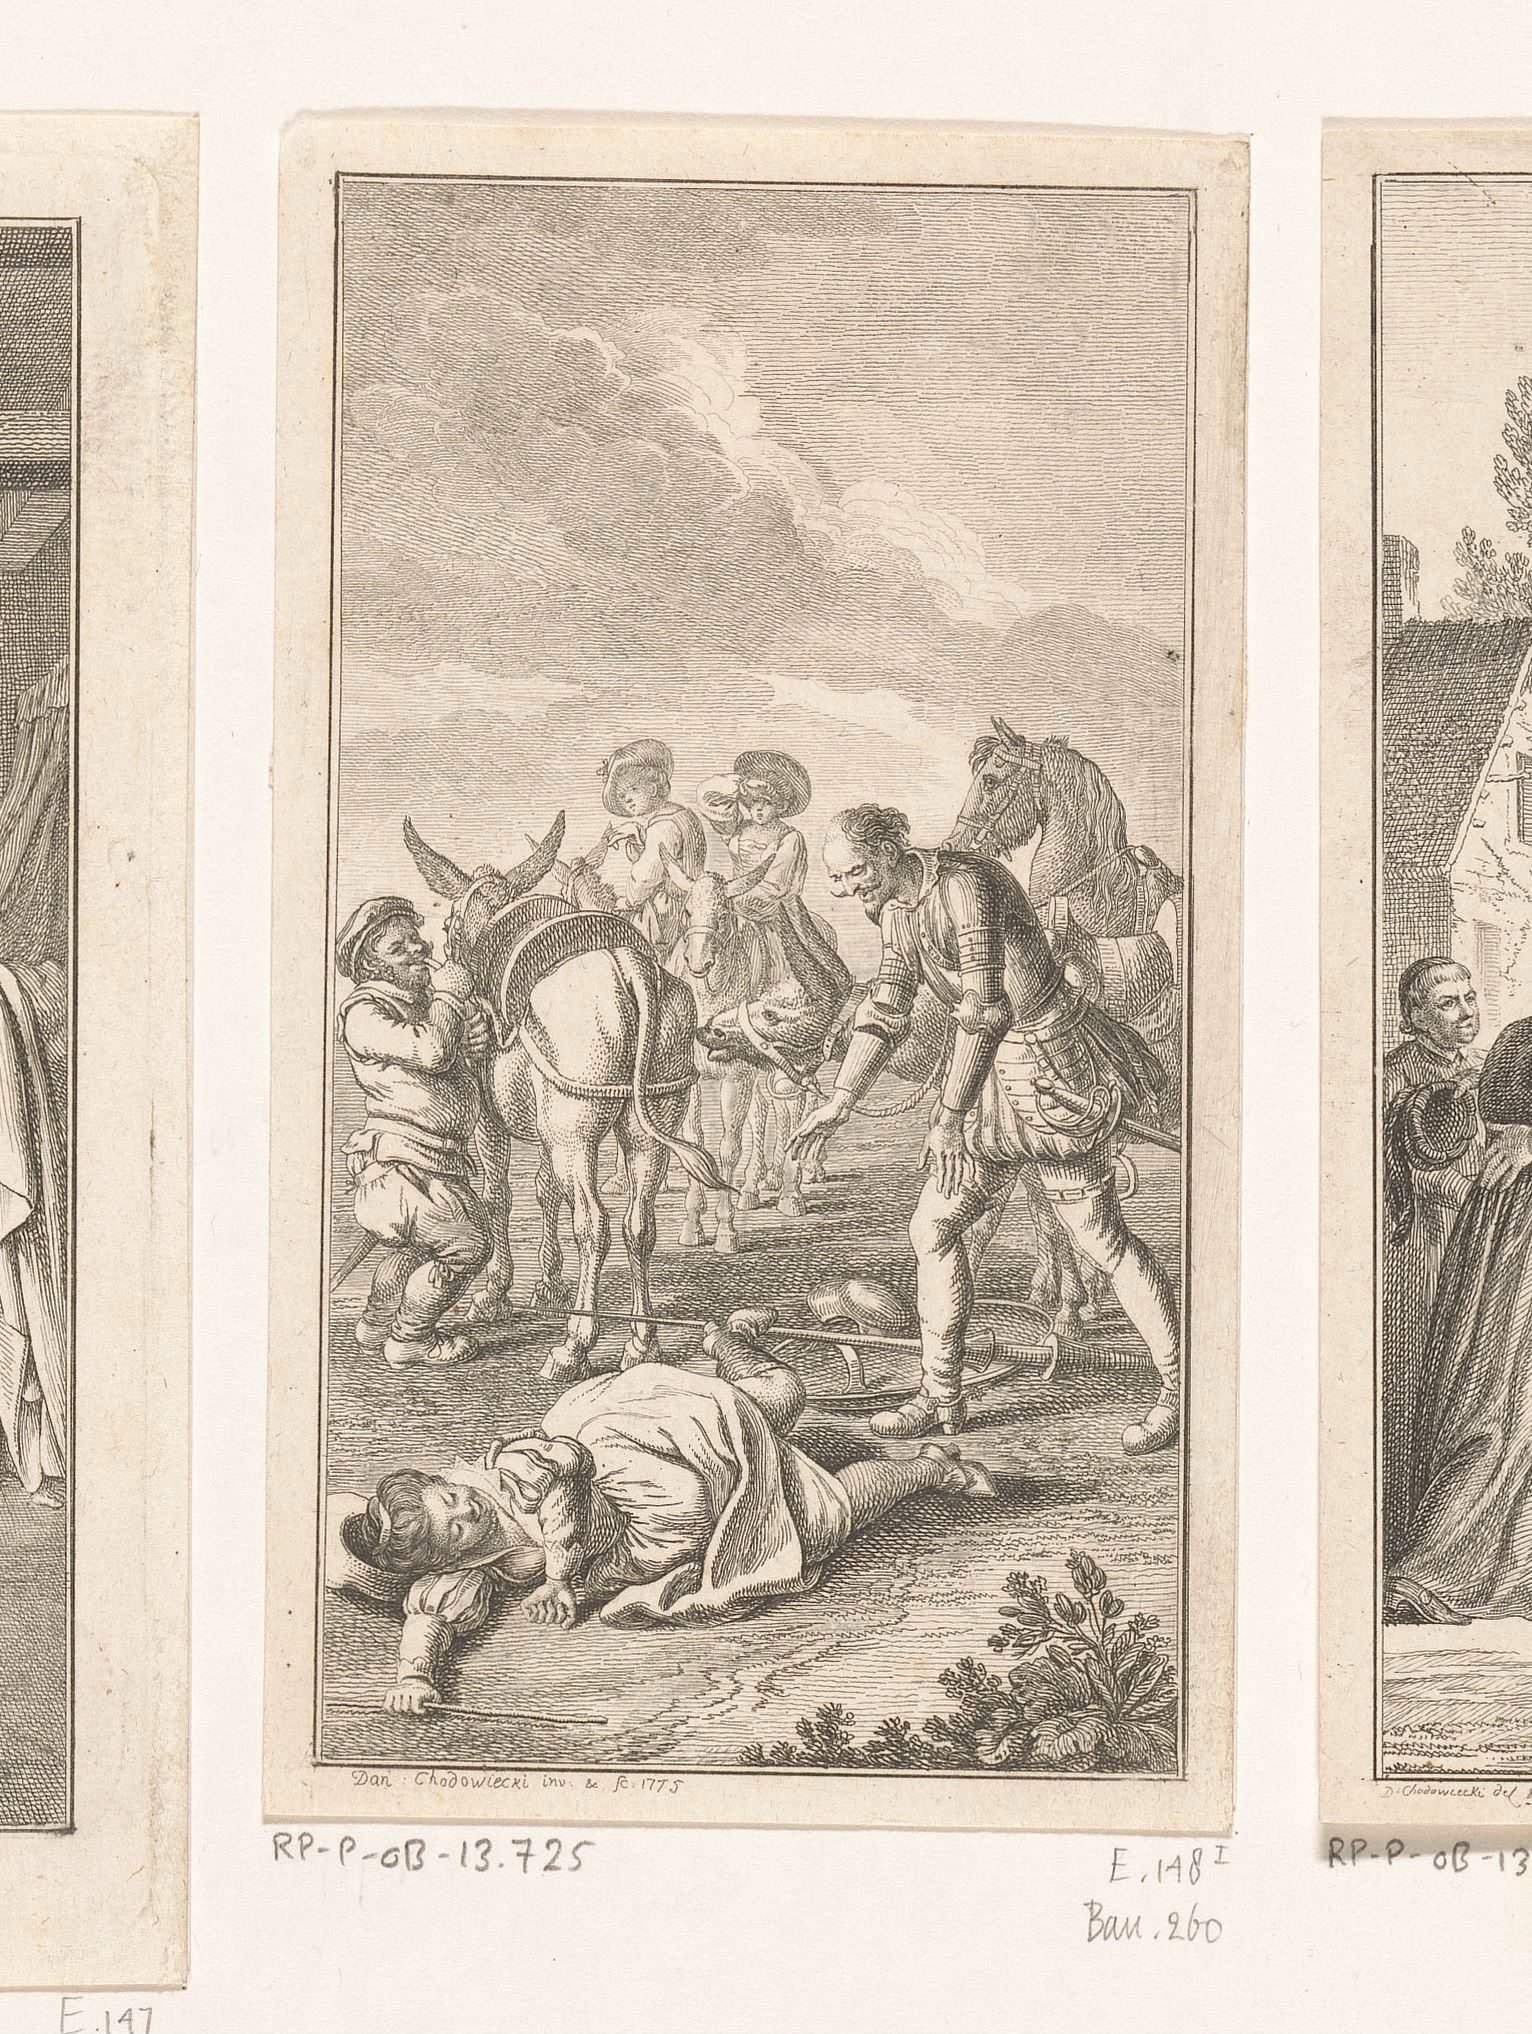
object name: print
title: Don Quichot helpt de van haar ezel gevallen boerin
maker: daniel nikolaus chodowiecki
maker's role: draughtsman, print maker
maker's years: 1726-1801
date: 1775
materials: paper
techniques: etching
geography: berlin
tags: don quixote, accident with horse (or kindred animal)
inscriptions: collector's mark: Lugt 2228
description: Sancho Panza heeft drie boerinnen gevonden die zich willen voordoen als Dulcinea en haar hofdames. De boerin die moet doorgaan voor Dulcinea spoort haar ezel zo krachtig aan dat deze haar van zijn rug werpt. Don Quichot rept zich om haar te helpen terwijl Sancho Panza in de achtergrond de ezel vasthoudt.